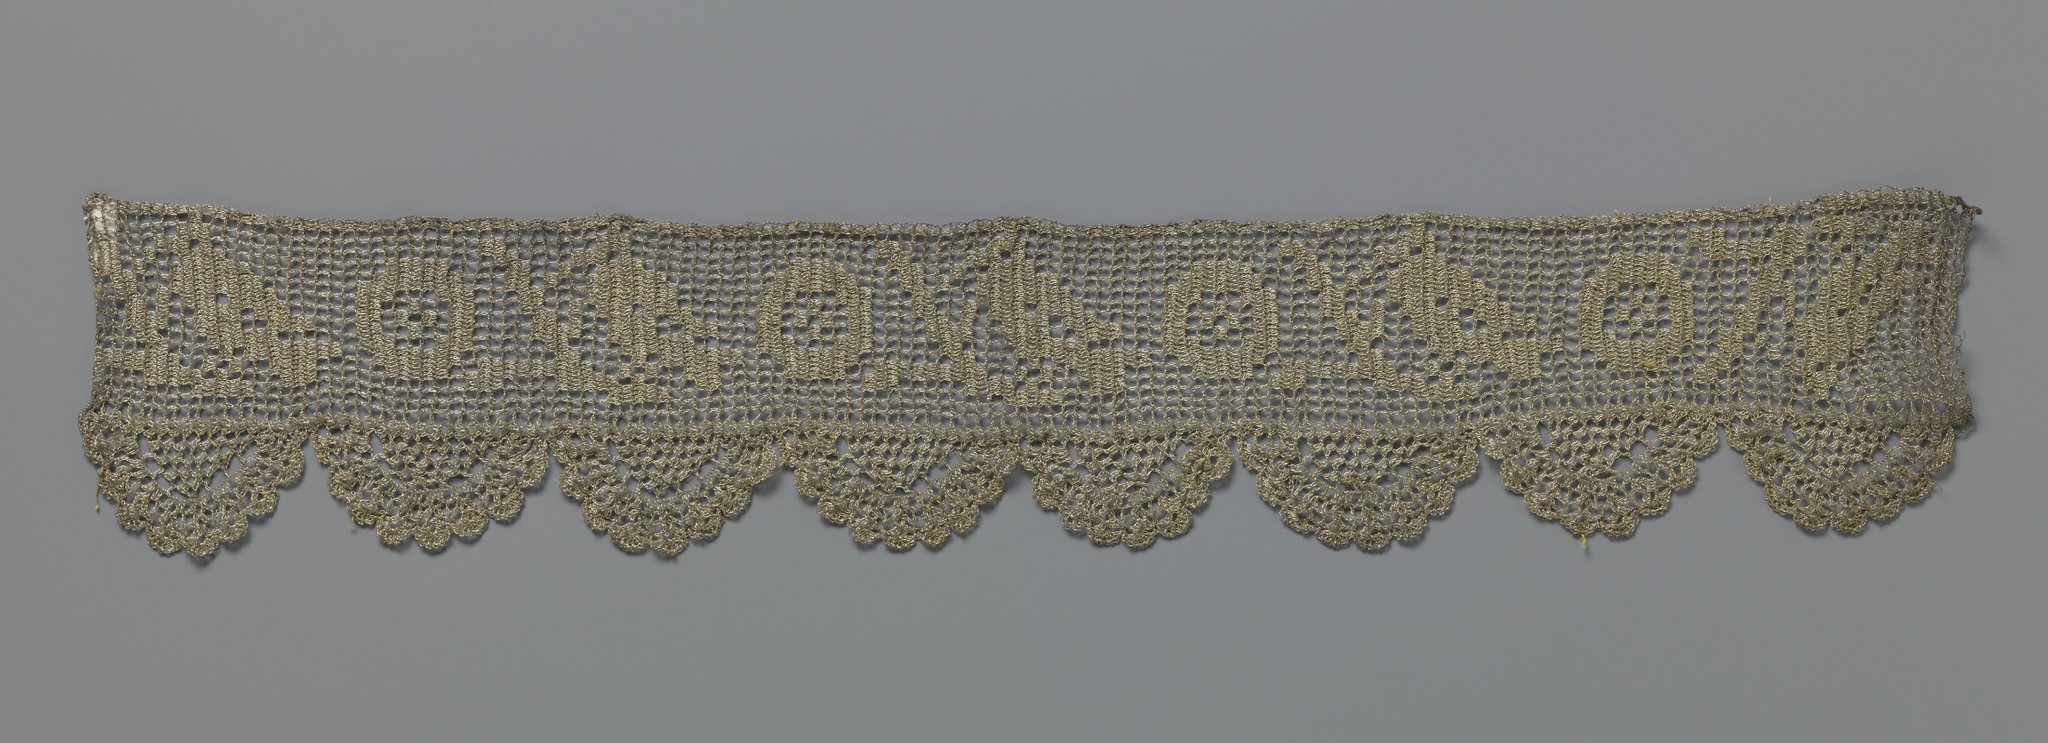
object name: strip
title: Strook gehaakte kant van gouddraad met een vogel op een tak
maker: Anonymous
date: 1800-1899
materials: metal thread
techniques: crocheted lace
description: Strook gehaakte kant van goudkleurig metaaldraad, filethaakwerk. Repetitief motief van afwisselend een cirkel en een vogel op een tak. Acht halfronde schulpen aan de onderzijde.